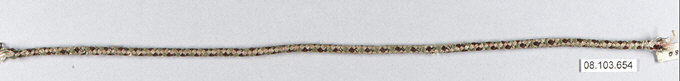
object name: cord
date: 1701-1900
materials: silk